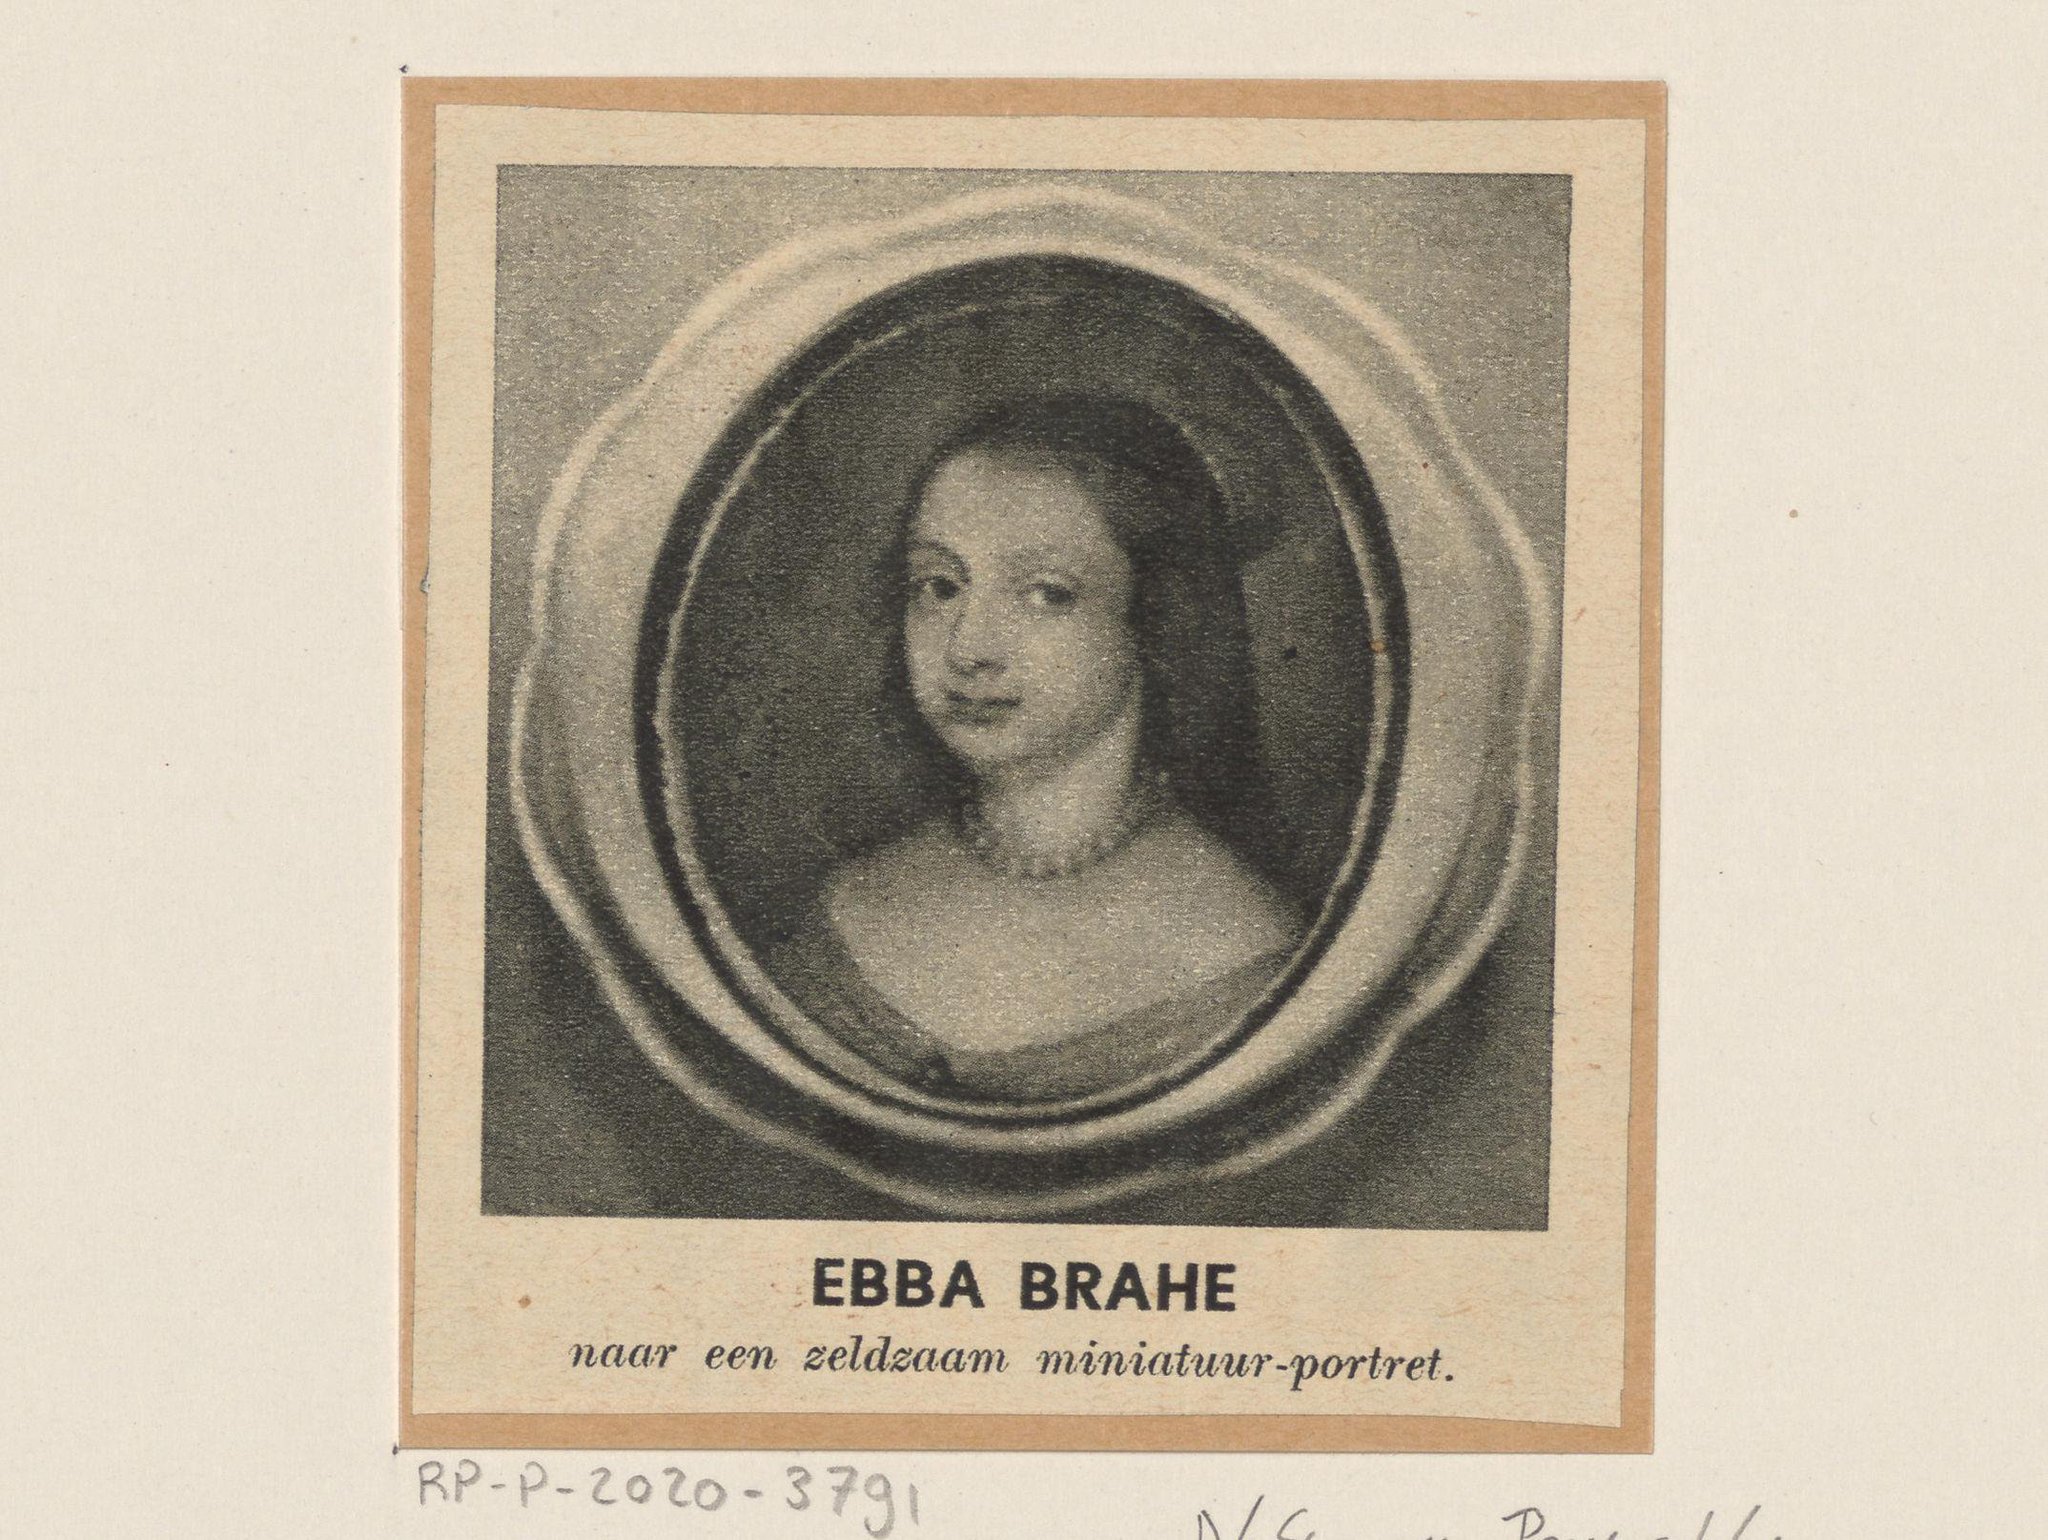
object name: photomechanical print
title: Portret van Ebba Brahe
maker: Anonymous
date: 1895-1920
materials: paper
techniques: rotogravure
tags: historical persons - bb - woman